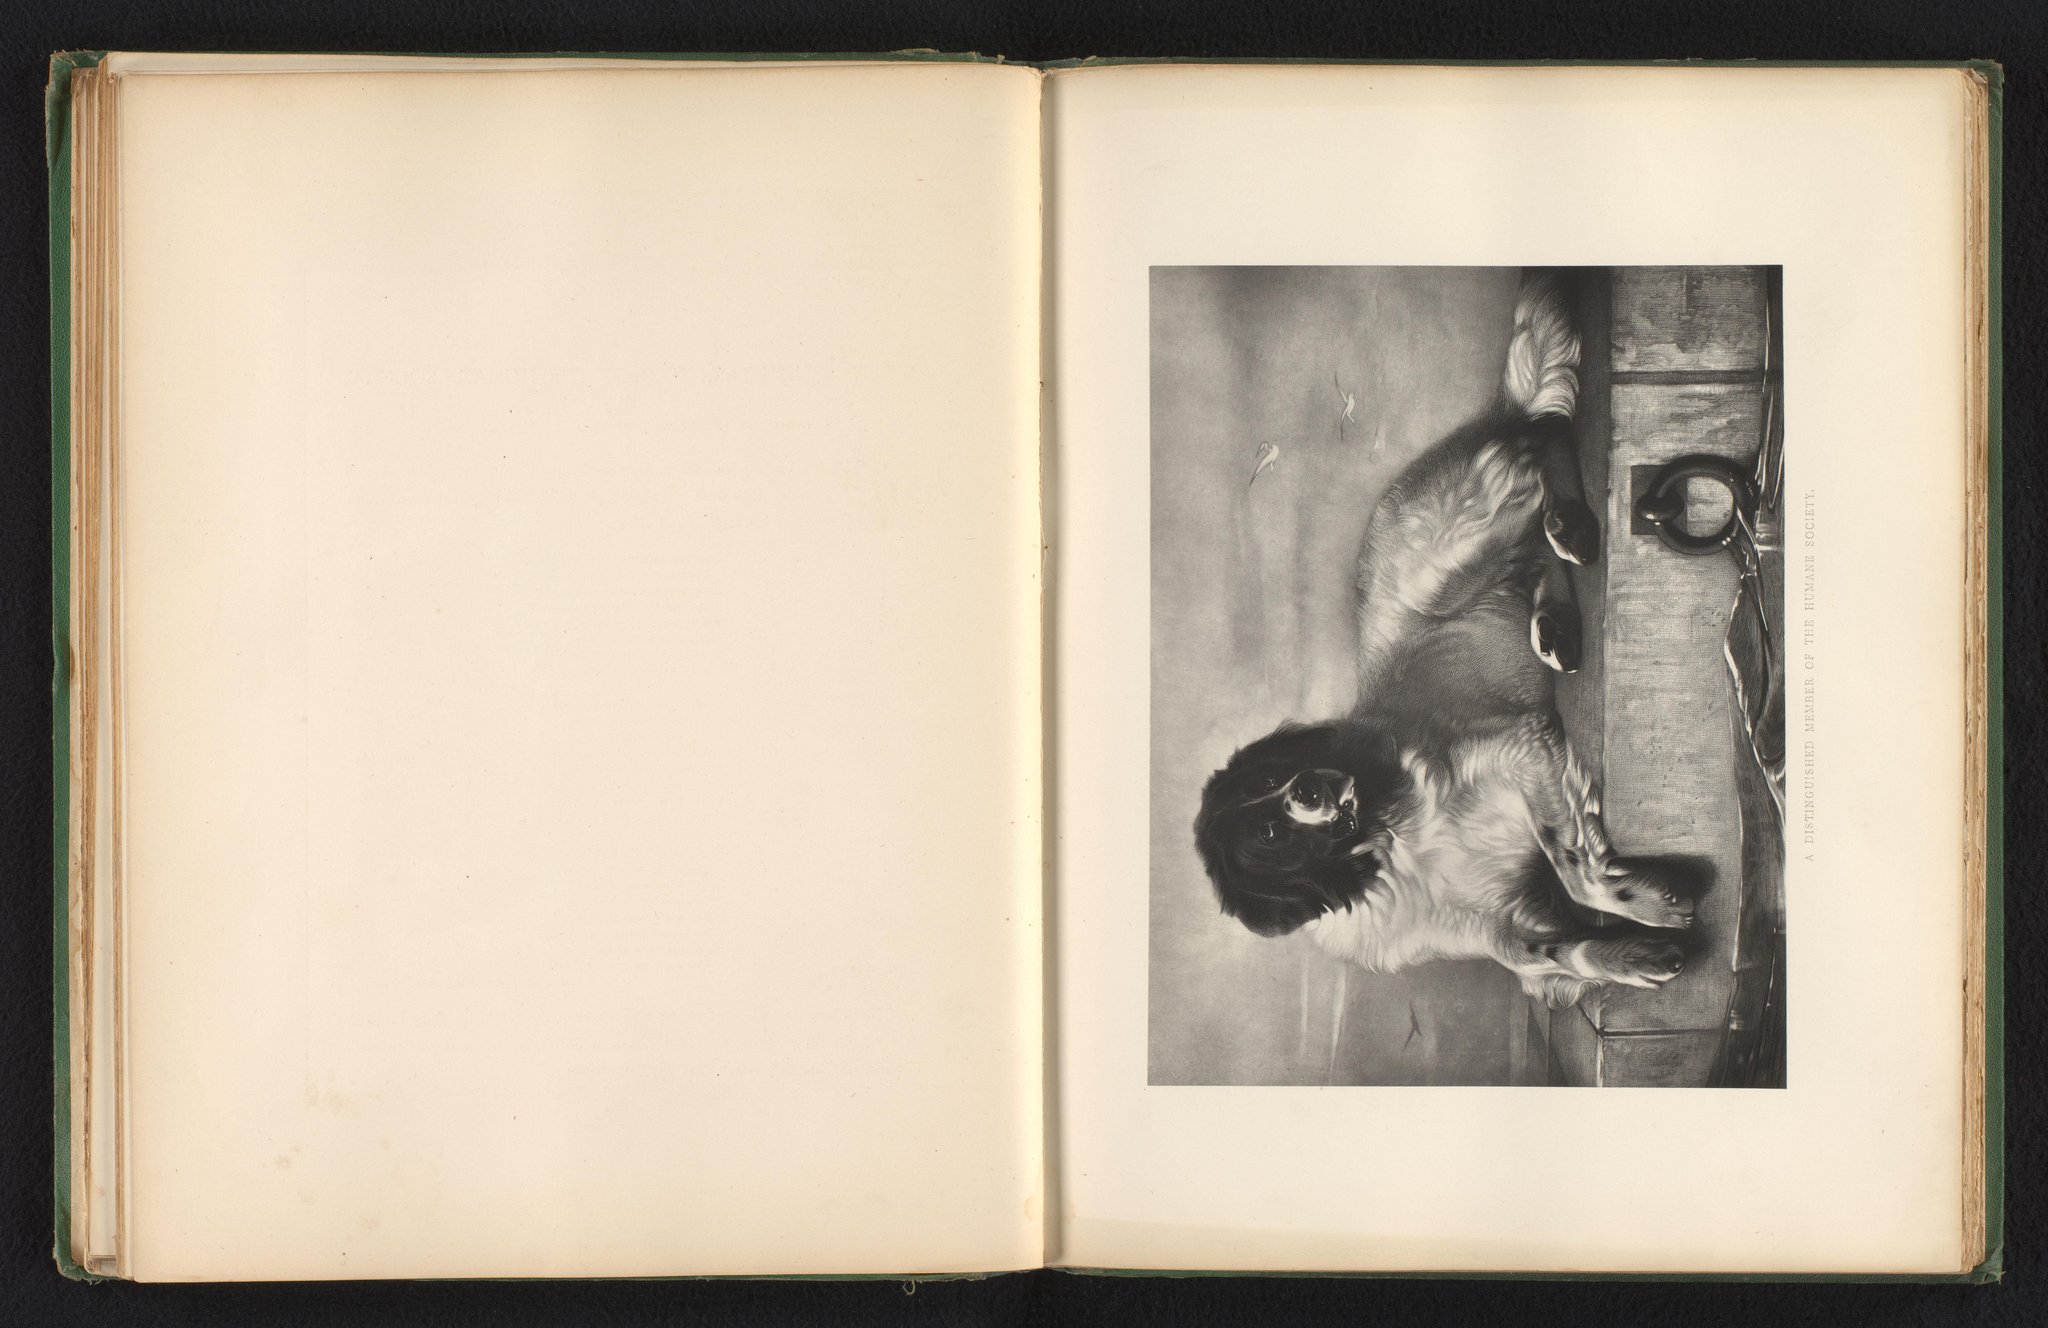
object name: page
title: A distinguished member of the humane society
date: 1878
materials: paper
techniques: woodburytype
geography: london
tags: dog